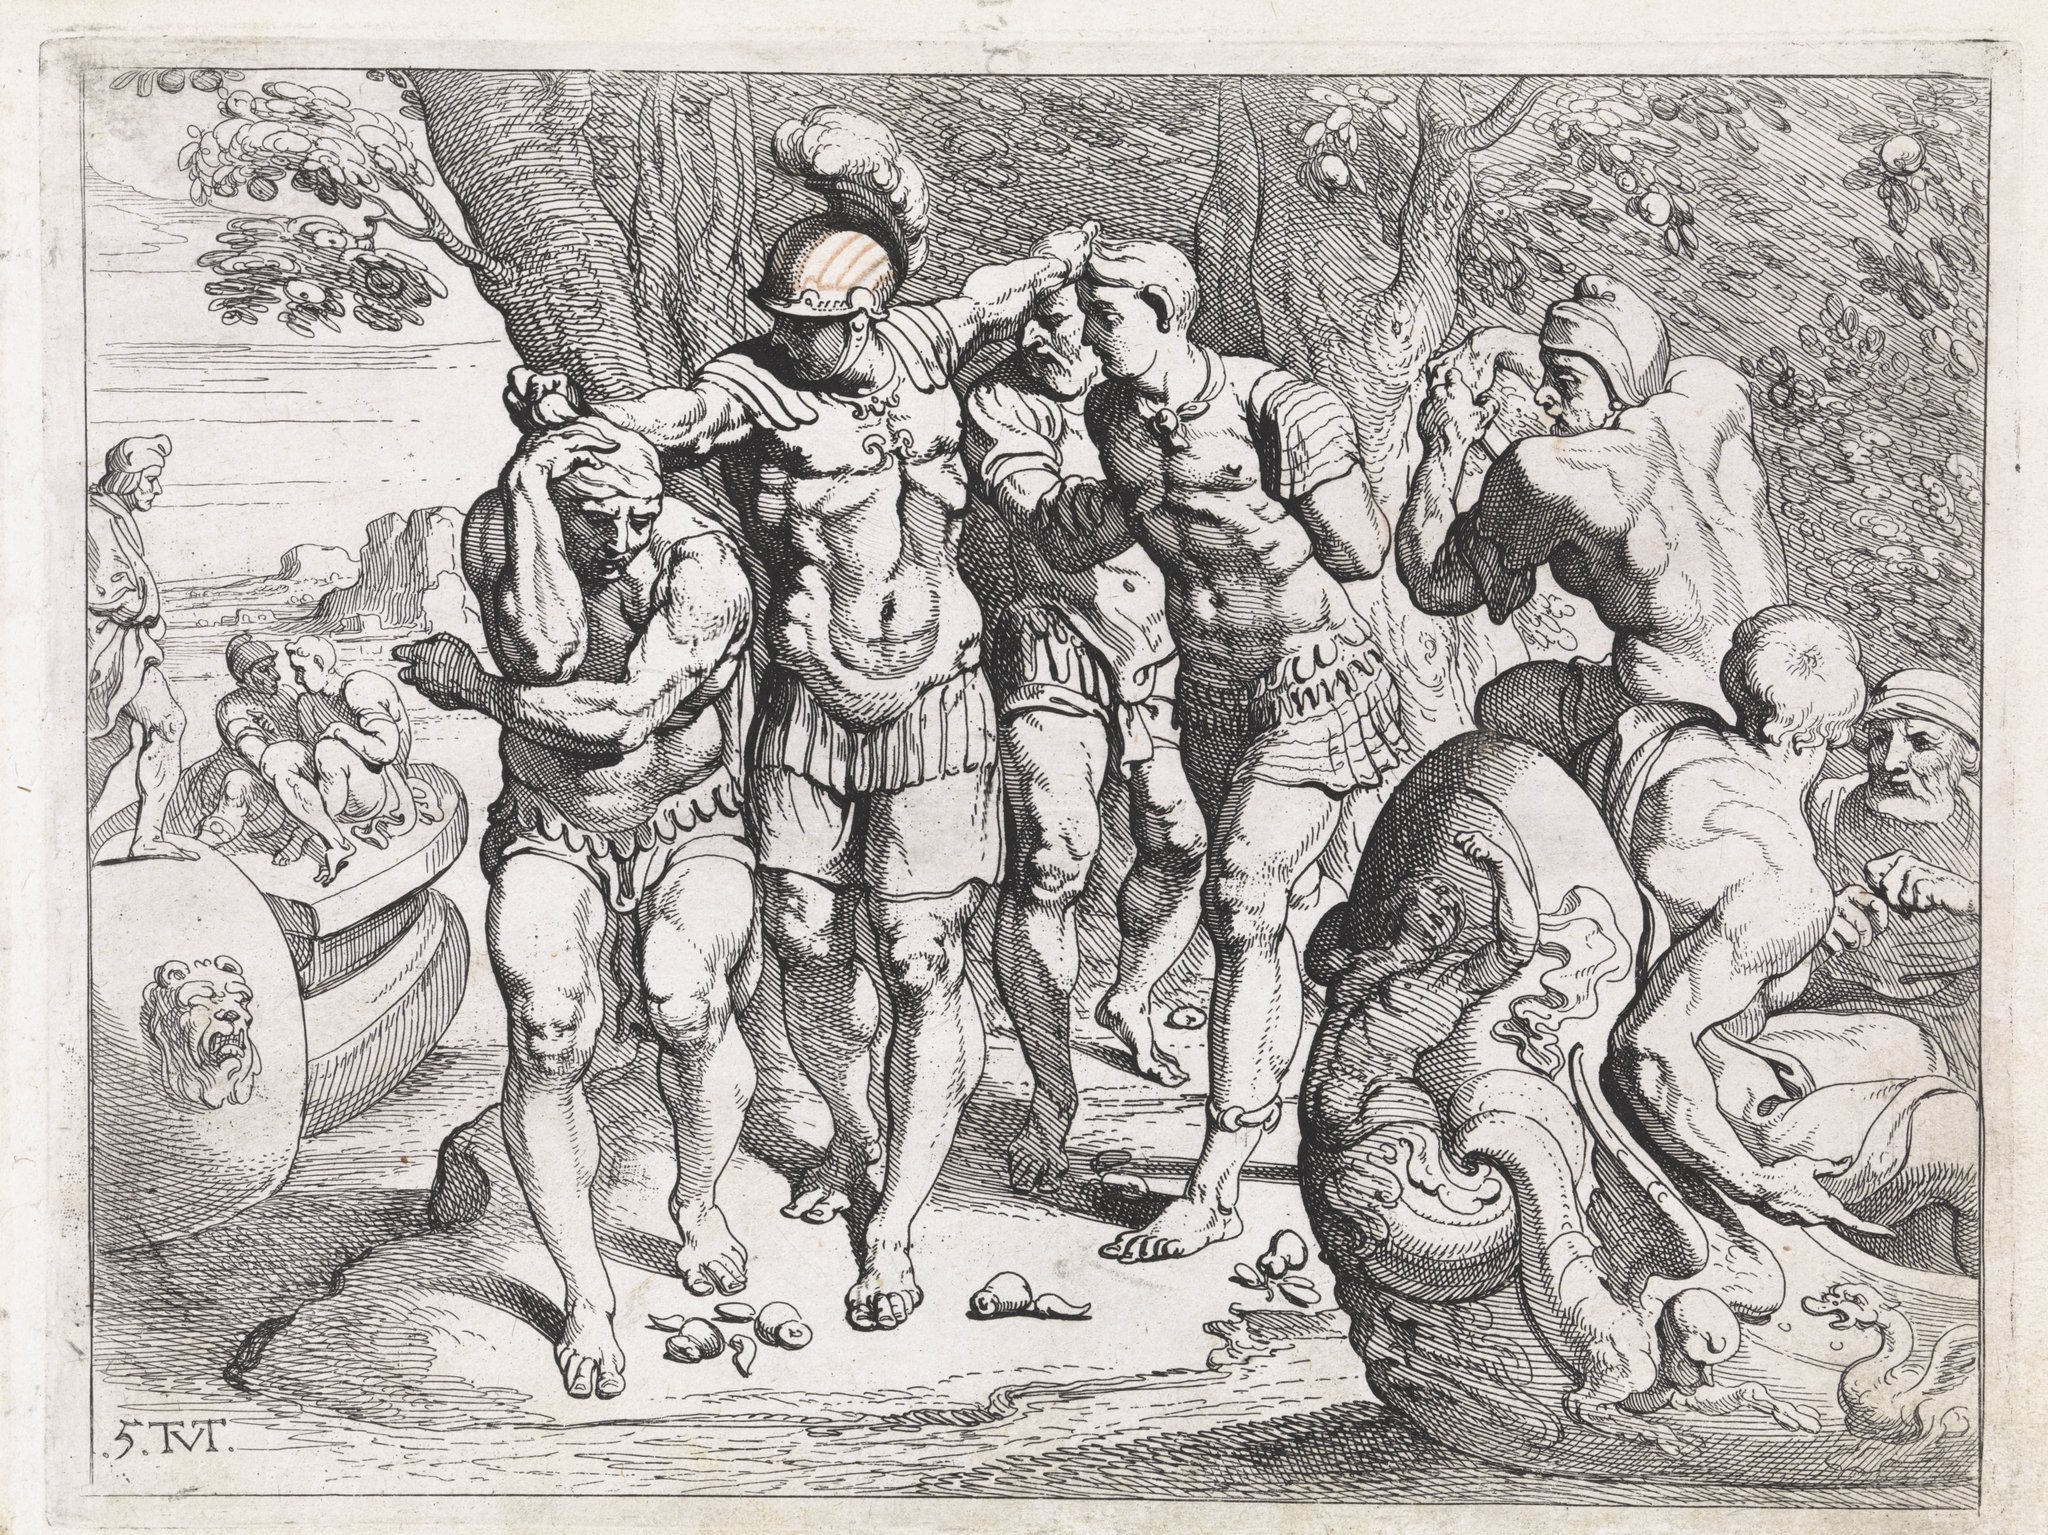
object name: print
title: Odysseus in het land van de lotuseters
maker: theodoor van thulden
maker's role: draughtsman, painter, print maker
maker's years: 1606-1669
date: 1632-1633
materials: paper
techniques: engraving, etching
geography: paris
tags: ulysses and his men in the land of the lotus-eaters (homer, odyssey ix)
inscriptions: collector's mark: Lugt 2228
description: Op het eiland van de lotuseters grijpt Odysseus zijn drie verkenners bij de haren en neemt ze mee naar de schepen. Nadat de verkenners van de lotusbloemen op het eiland hadden gegeten wilden ze niet meer vertrekken.